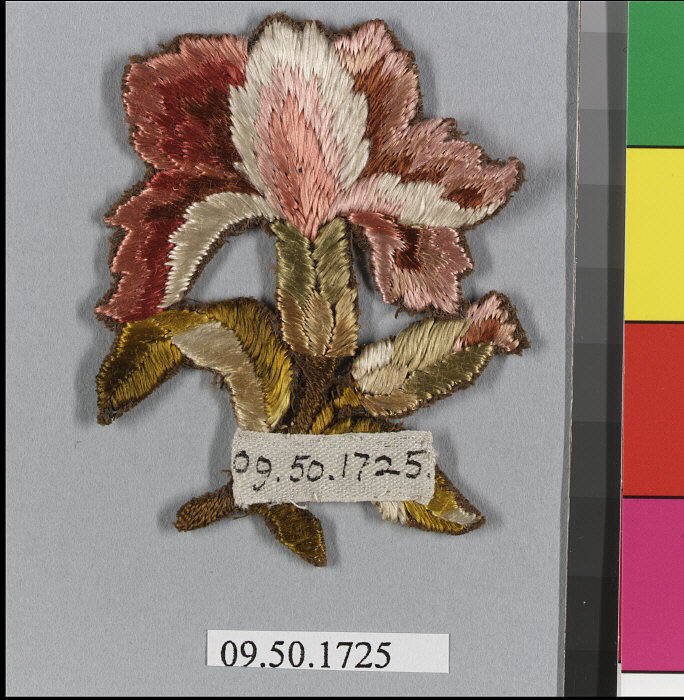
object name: piece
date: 1801-1900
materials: canvas, silk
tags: flowers,leaves